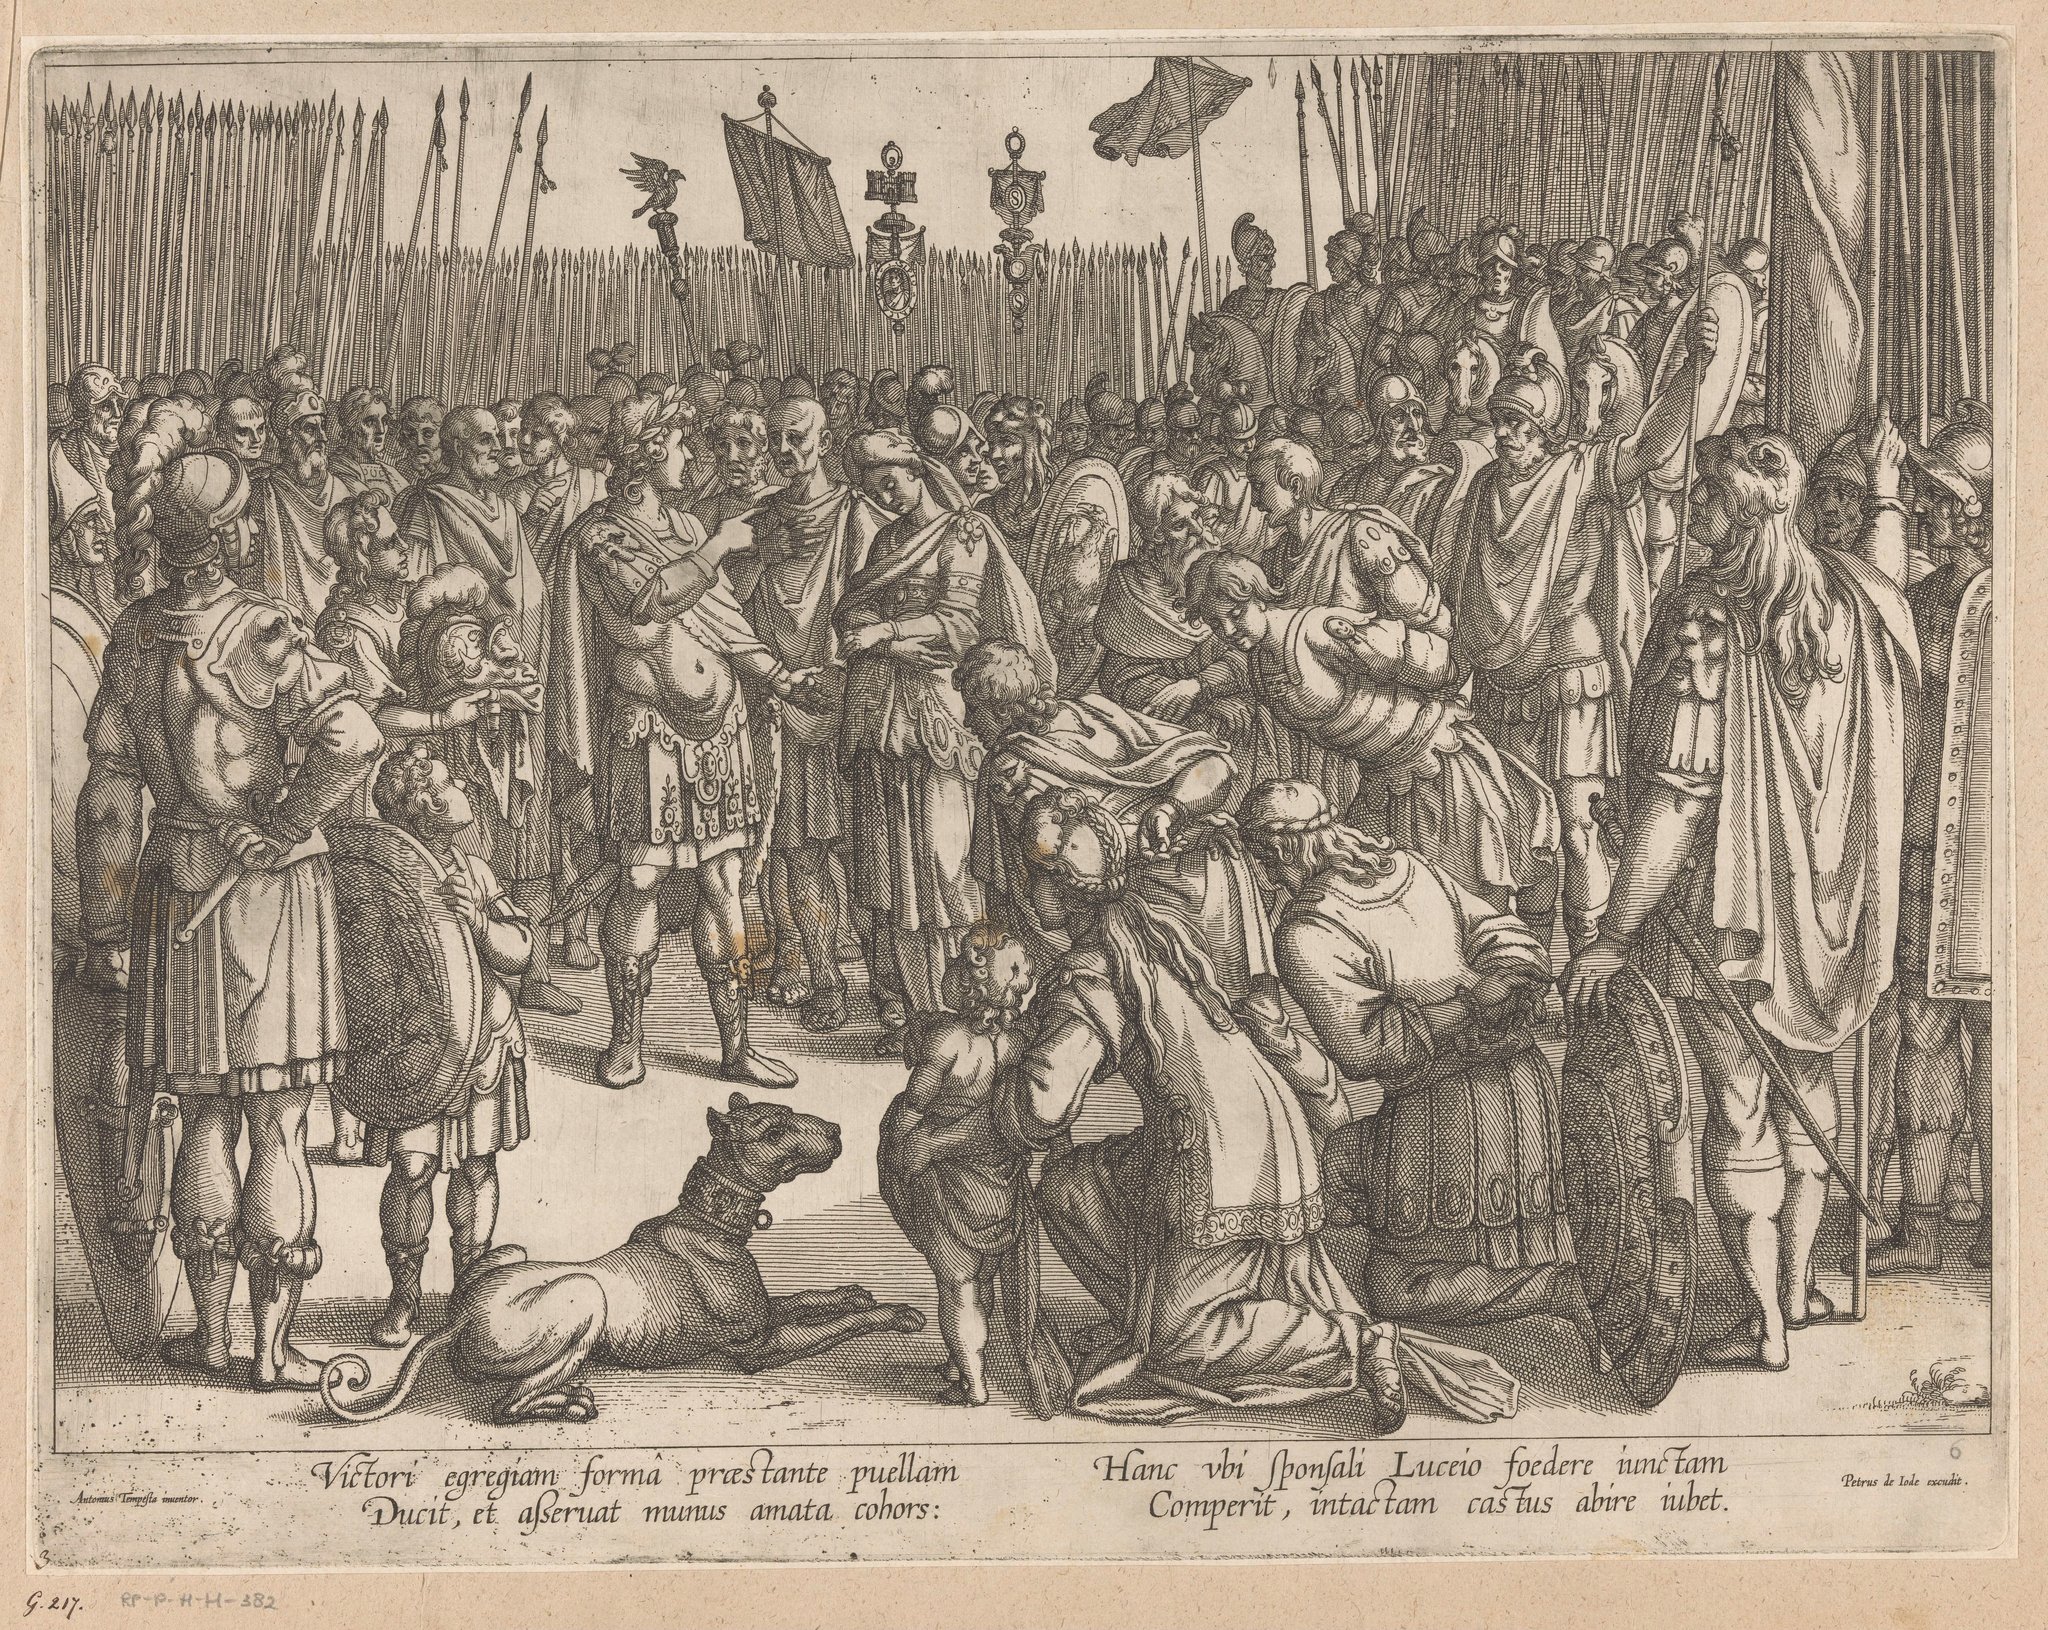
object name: print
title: Edelmoedigheid van Scipio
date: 1620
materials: paper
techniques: etching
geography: italy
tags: rome, the continence of scipio: he restores a captive woman to her bridegroom allucius, who kneels before him; the ransom offered by the bride's parents is given to allucius as a wedding-gift, (story of) p. cornelius scipio africanus major, the soldier; the soldier's life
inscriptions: collector's mark: Lugt 11, number: ‘3’, collector's mark: ‘Hinloopen’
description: Scipio Africanus wordt omringd door zijn soldaten. Een schone maagd wordt voor hem gebracht. Scipio geeft de maagd ongedeerd terug aan haar verloofde Allucius. Versregels in het Latijn in ondermarge.